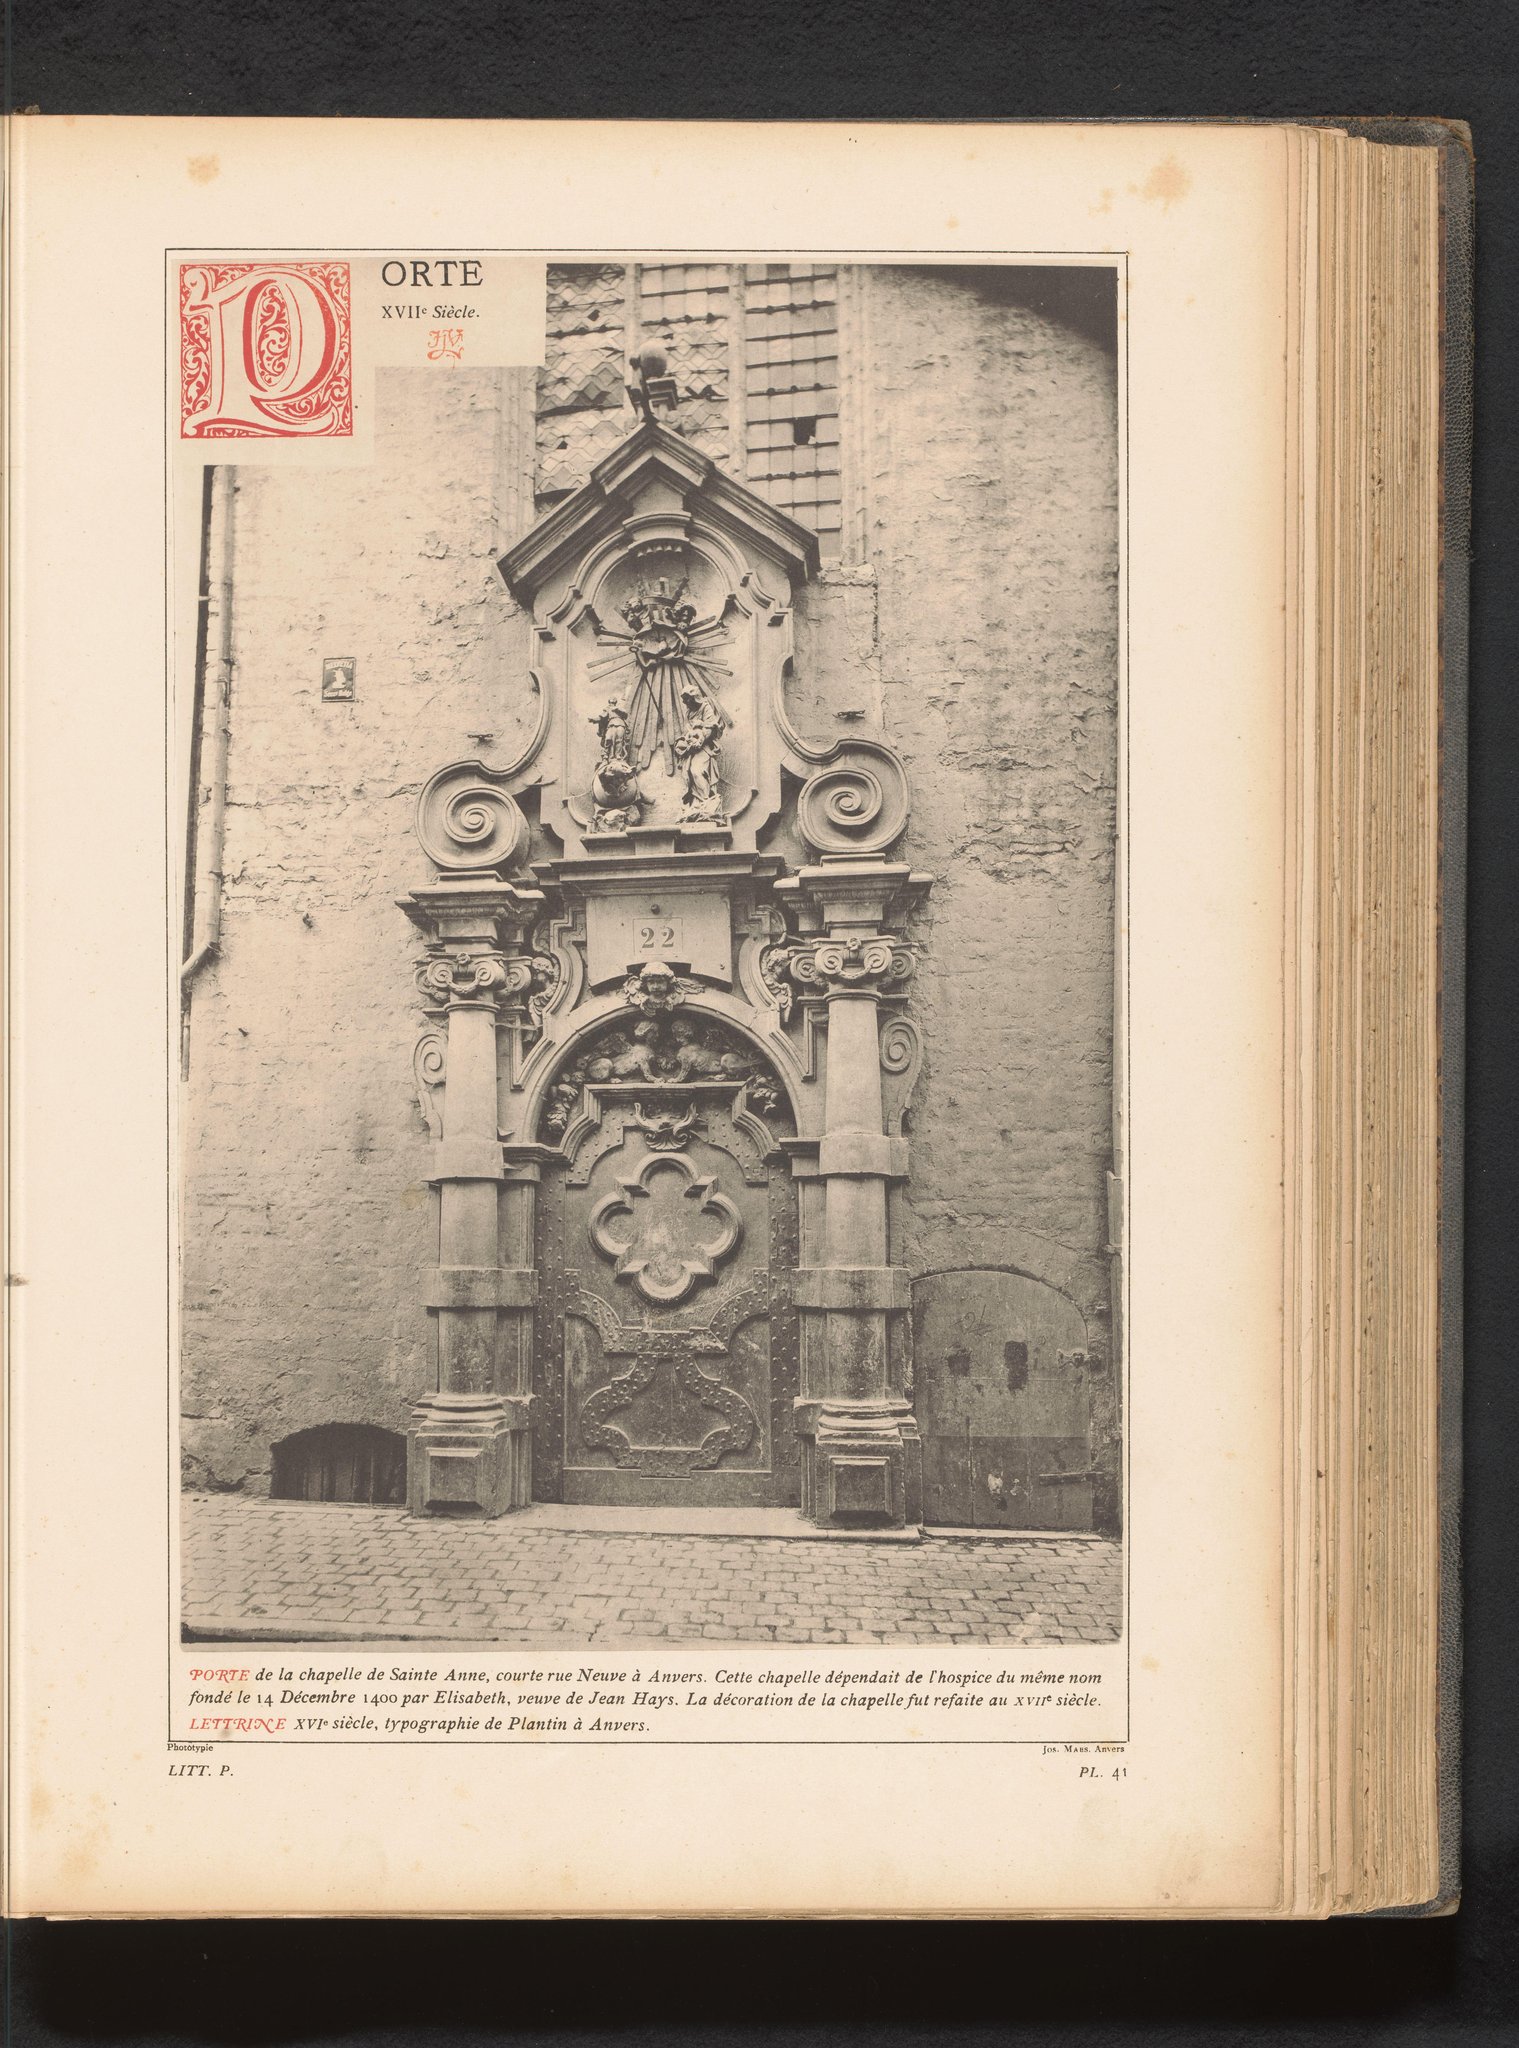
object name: photomechanical print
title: Deur van de Sint-Annakapel te Antwerpen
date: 1876-1881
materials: paper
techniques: photograph, photolithography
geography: antwerp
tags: monumental door, porch, 'aediculum', antwerp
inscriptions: monogram: ‘JJvY’, inscription: ‘PORTE de la chapelle (...)’, inscription: ‘LITT. P. - PL. 41.’